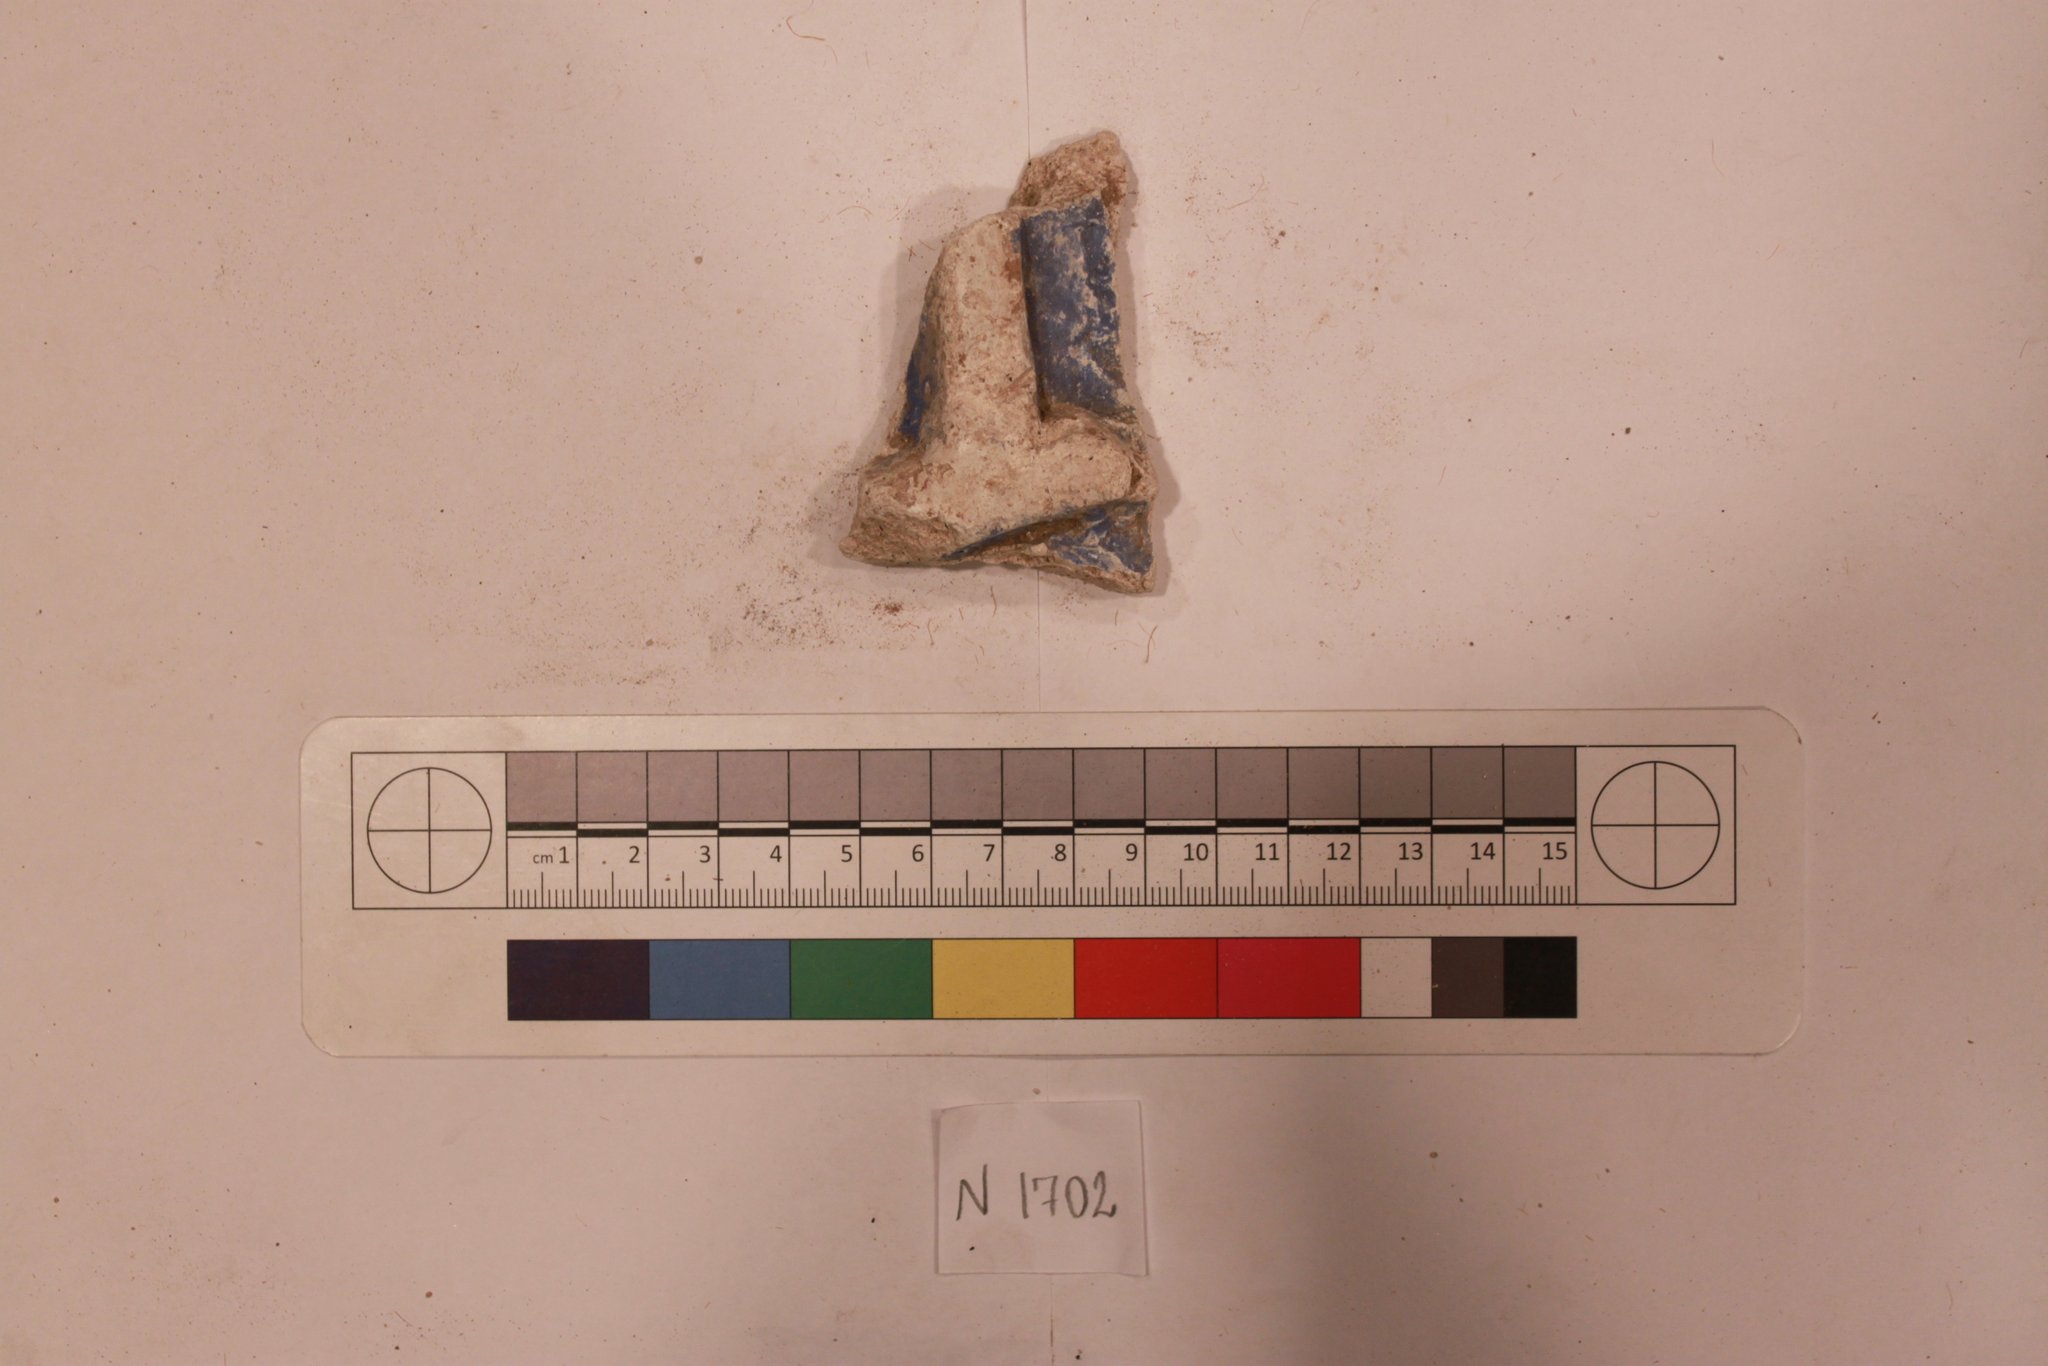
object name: fragment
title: Stucco Fragment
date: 701-1200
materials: plaster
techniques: carving, painting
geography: iran